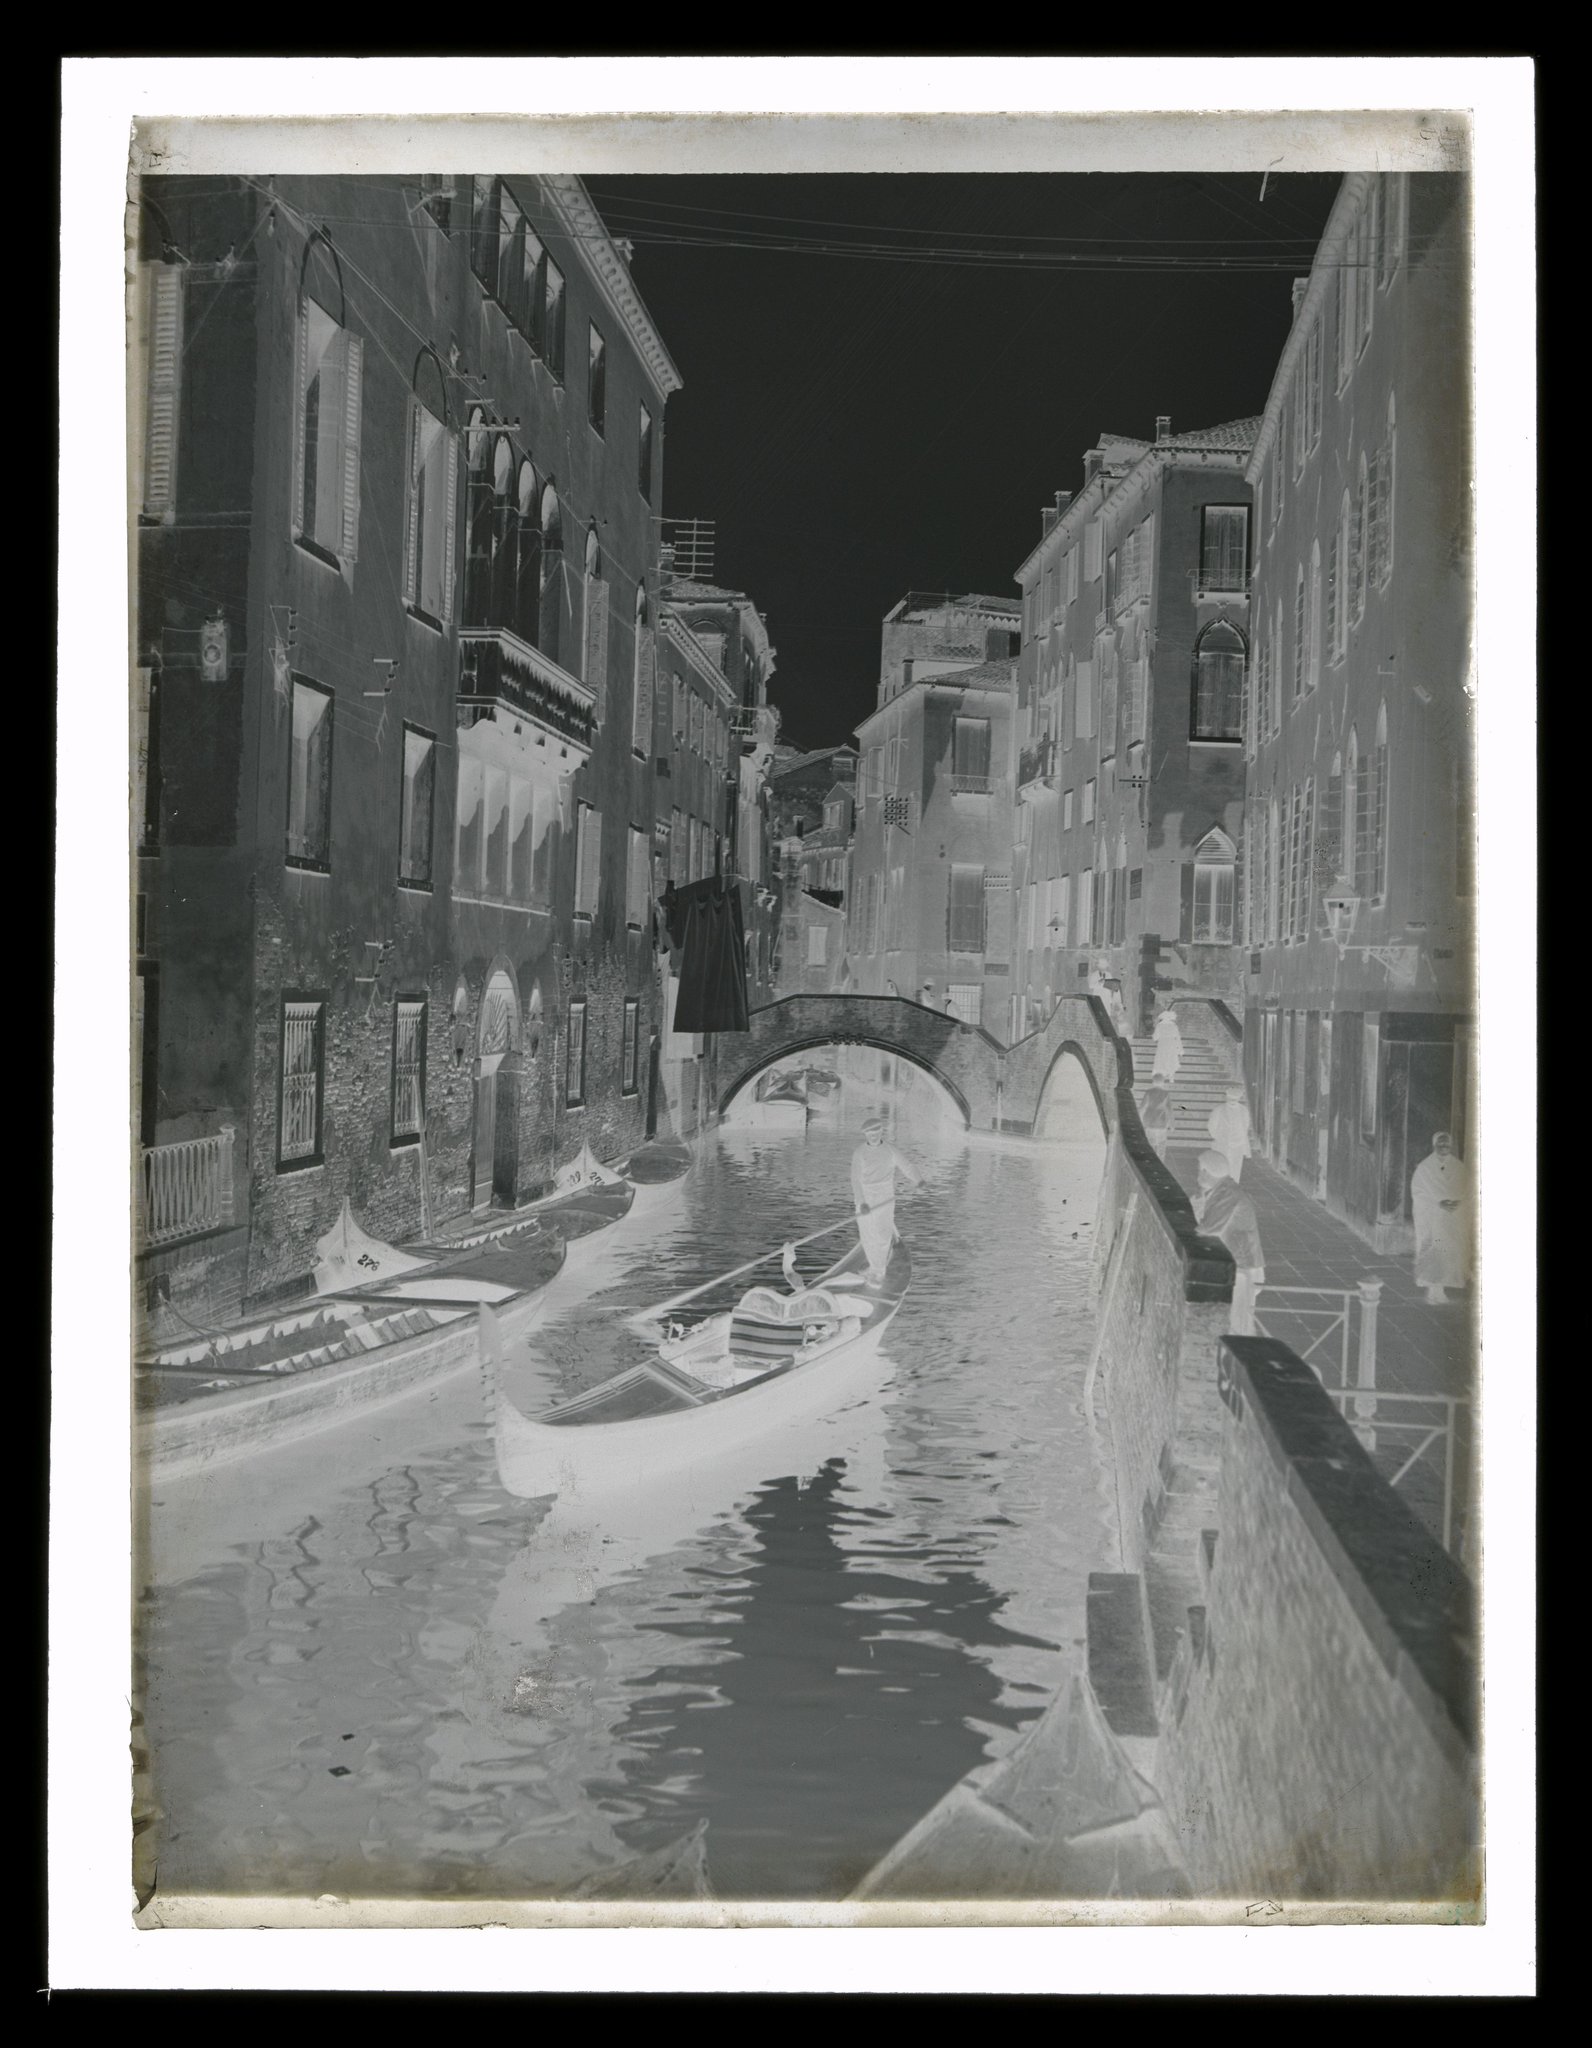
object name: photograph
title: Gezicht op een kanaal met gondel in Venetië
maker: Anonymous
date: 1907-1935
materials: glass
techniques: gelatin glass negative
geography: venice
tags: canals, waters (in city), gondola, venice